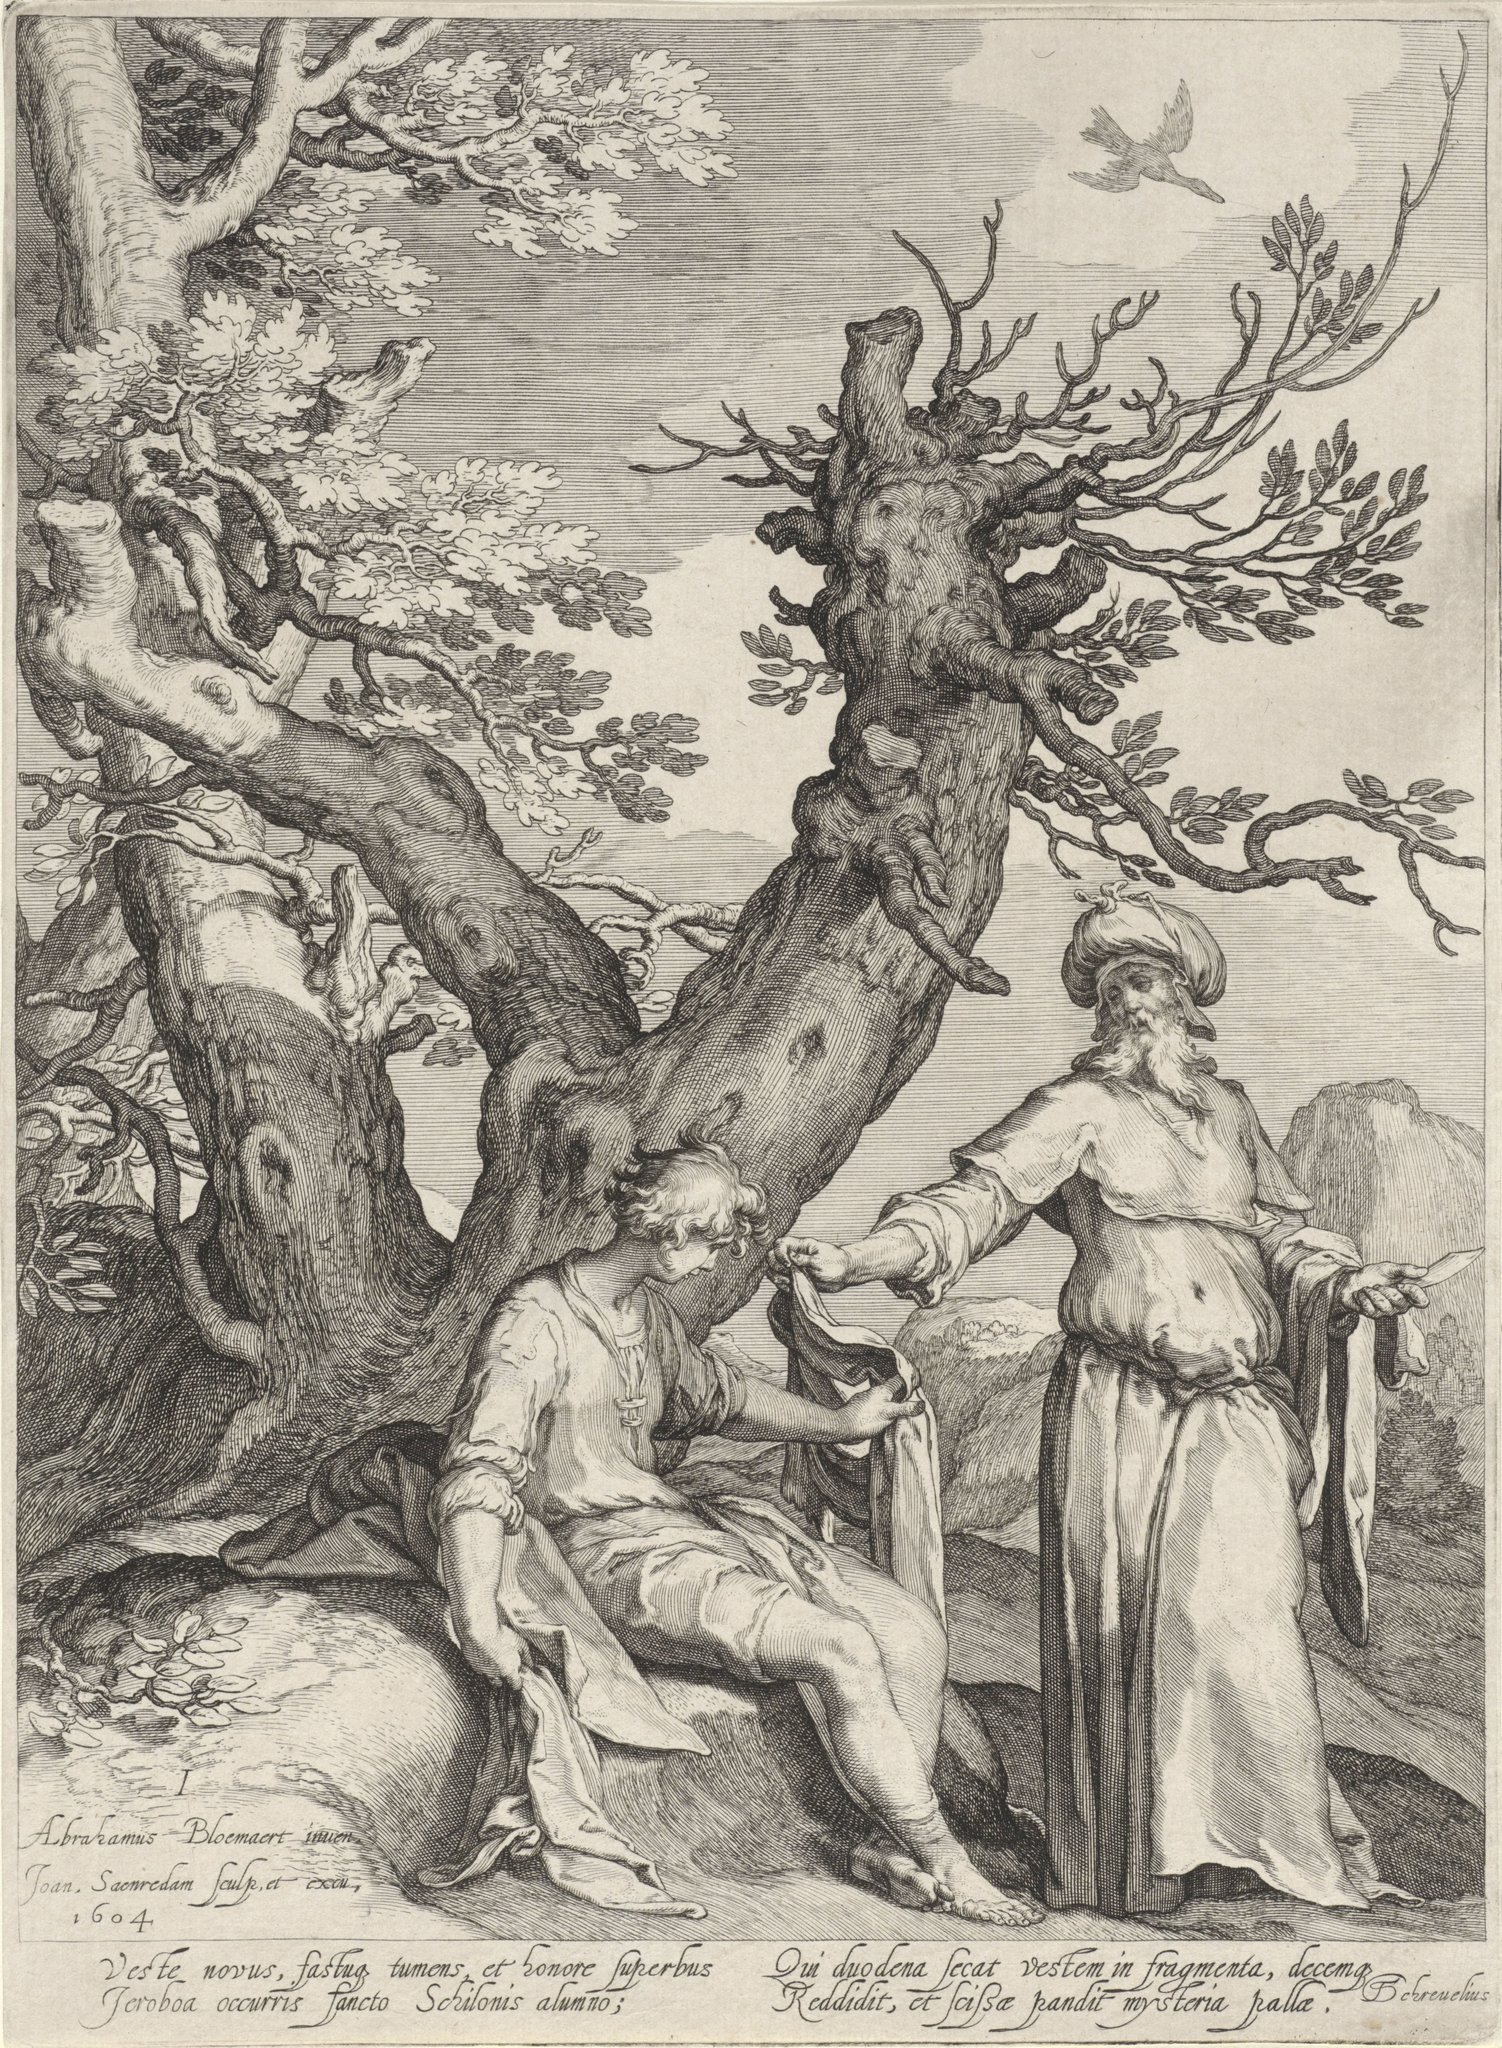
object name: print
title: Achia verdeelt zijn jas in twaalf stukken en overhandigt er tien aan Jerobeam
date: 1604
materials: paper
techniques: engraving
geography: assendelft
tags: meeting of jeroboam and the prophet ahijah; ahijah rends his garment in twelve pieces, ten of which he gives to jeroboam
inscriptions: collector's mark: Lugt 240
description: De profeet Achia heeft zijn mantel in twaalf stukken gescheurd en overhandigt tien stukken aan Jerobeam. De gescheurde mantel staat symbool voor de splitsing van het Joodse volk. Jerobeam werd koning van tien van de twaalf stammen. De prent heeft een Latijnse tekst in de ondermarge.